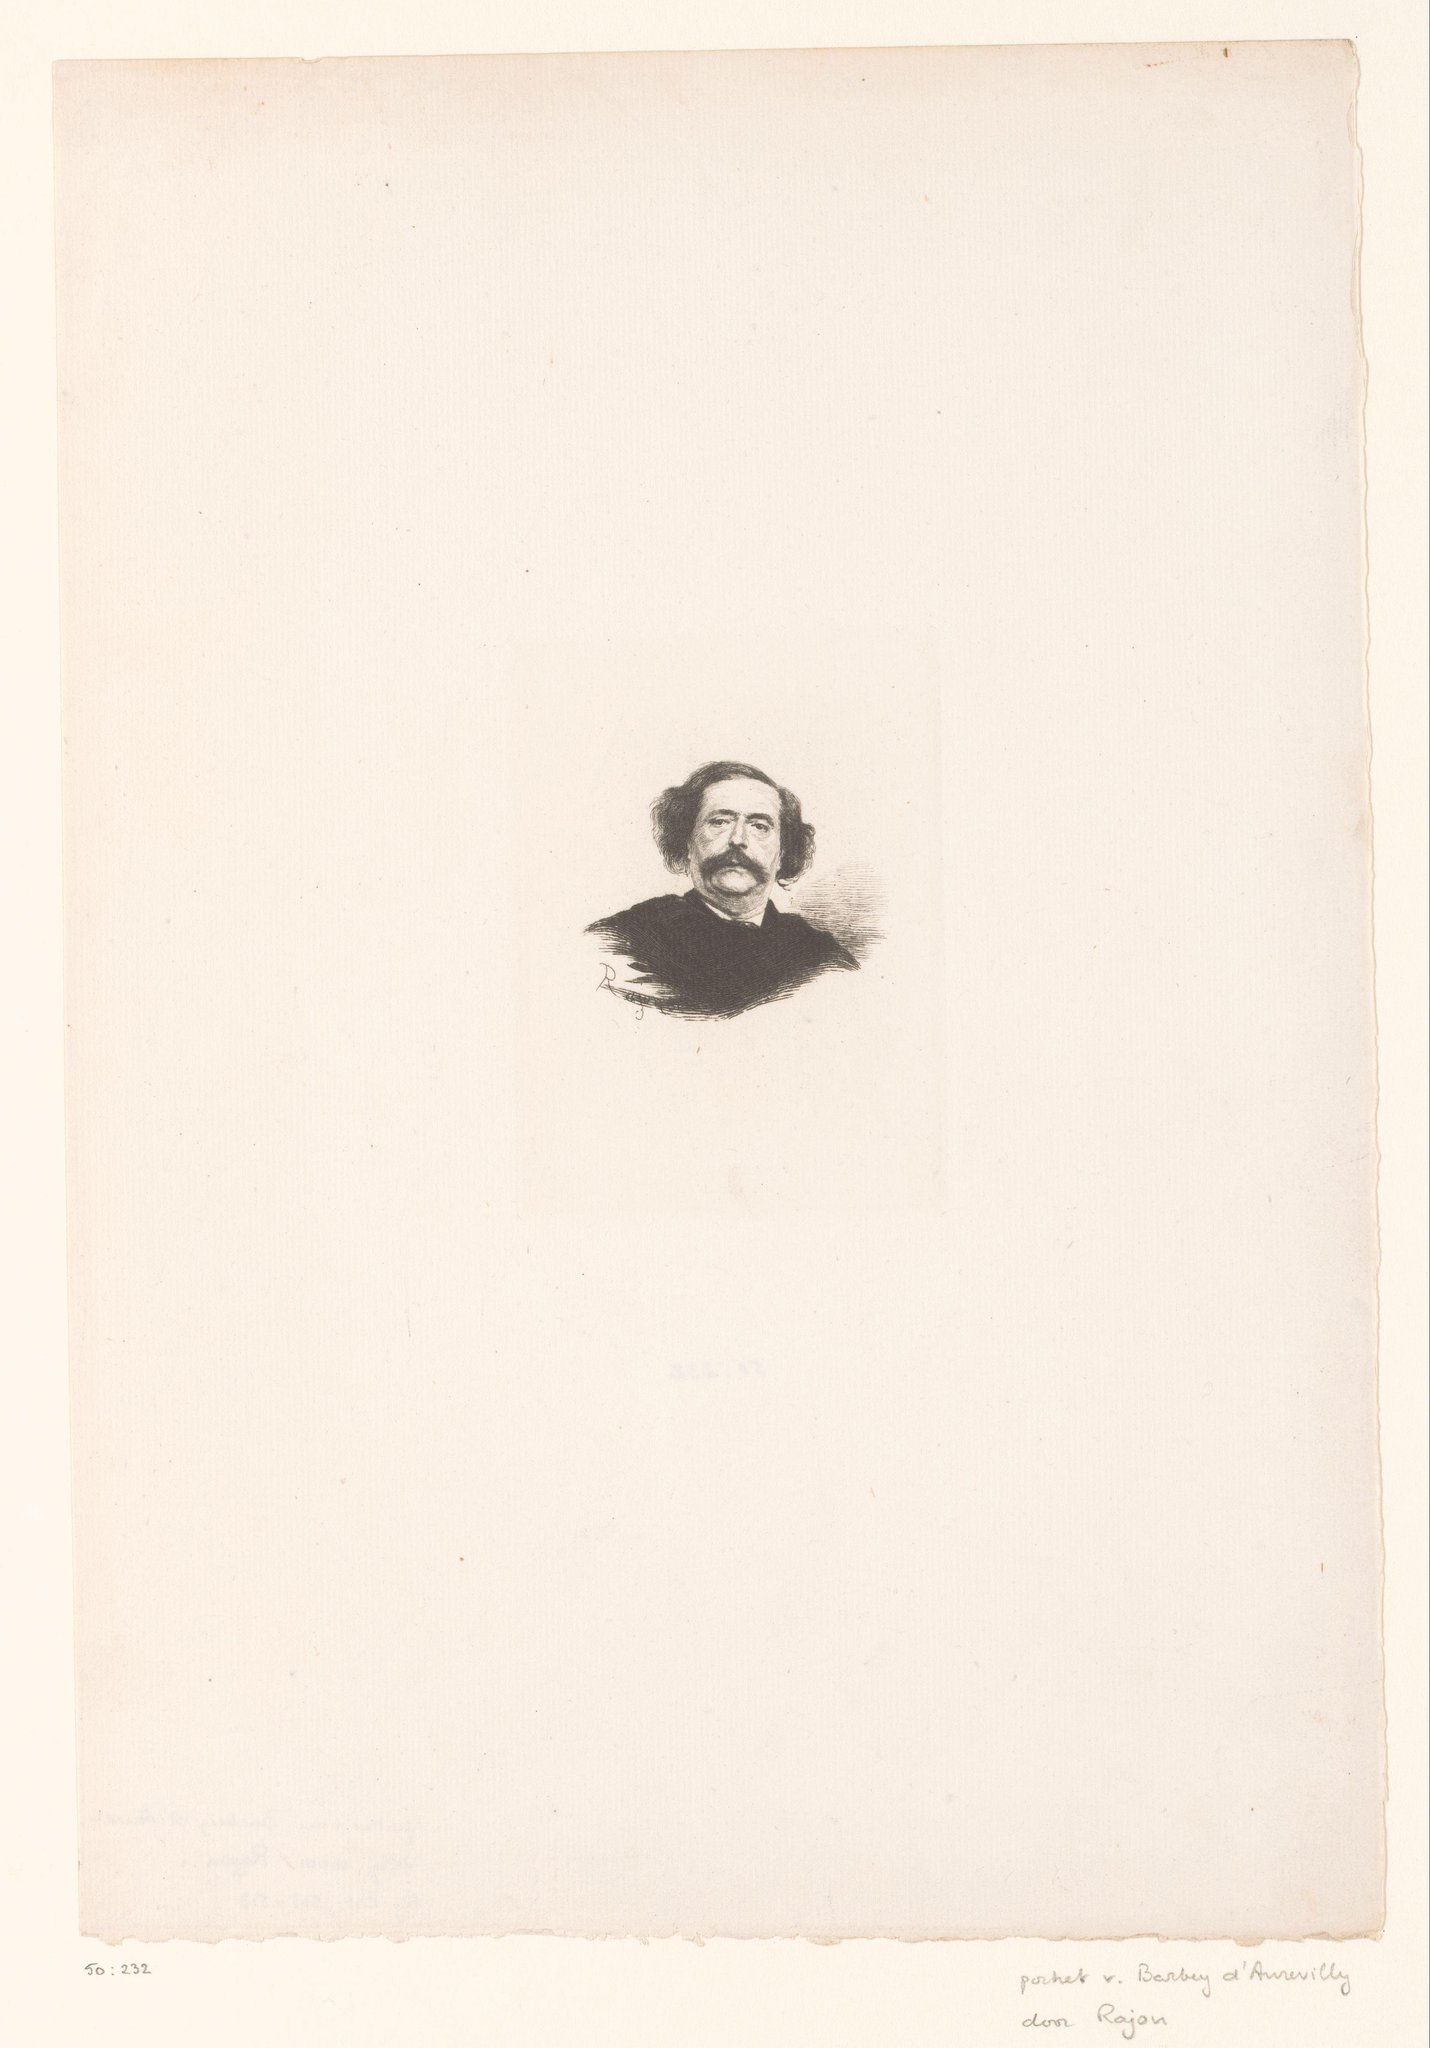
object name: photomechanical print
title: Dix eaux-fortes pour illustrer les diaboliques de J. Barbey-D'Aurevilly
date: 1886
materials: paper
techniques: photoaquatint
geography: paris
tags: paris, historical persons